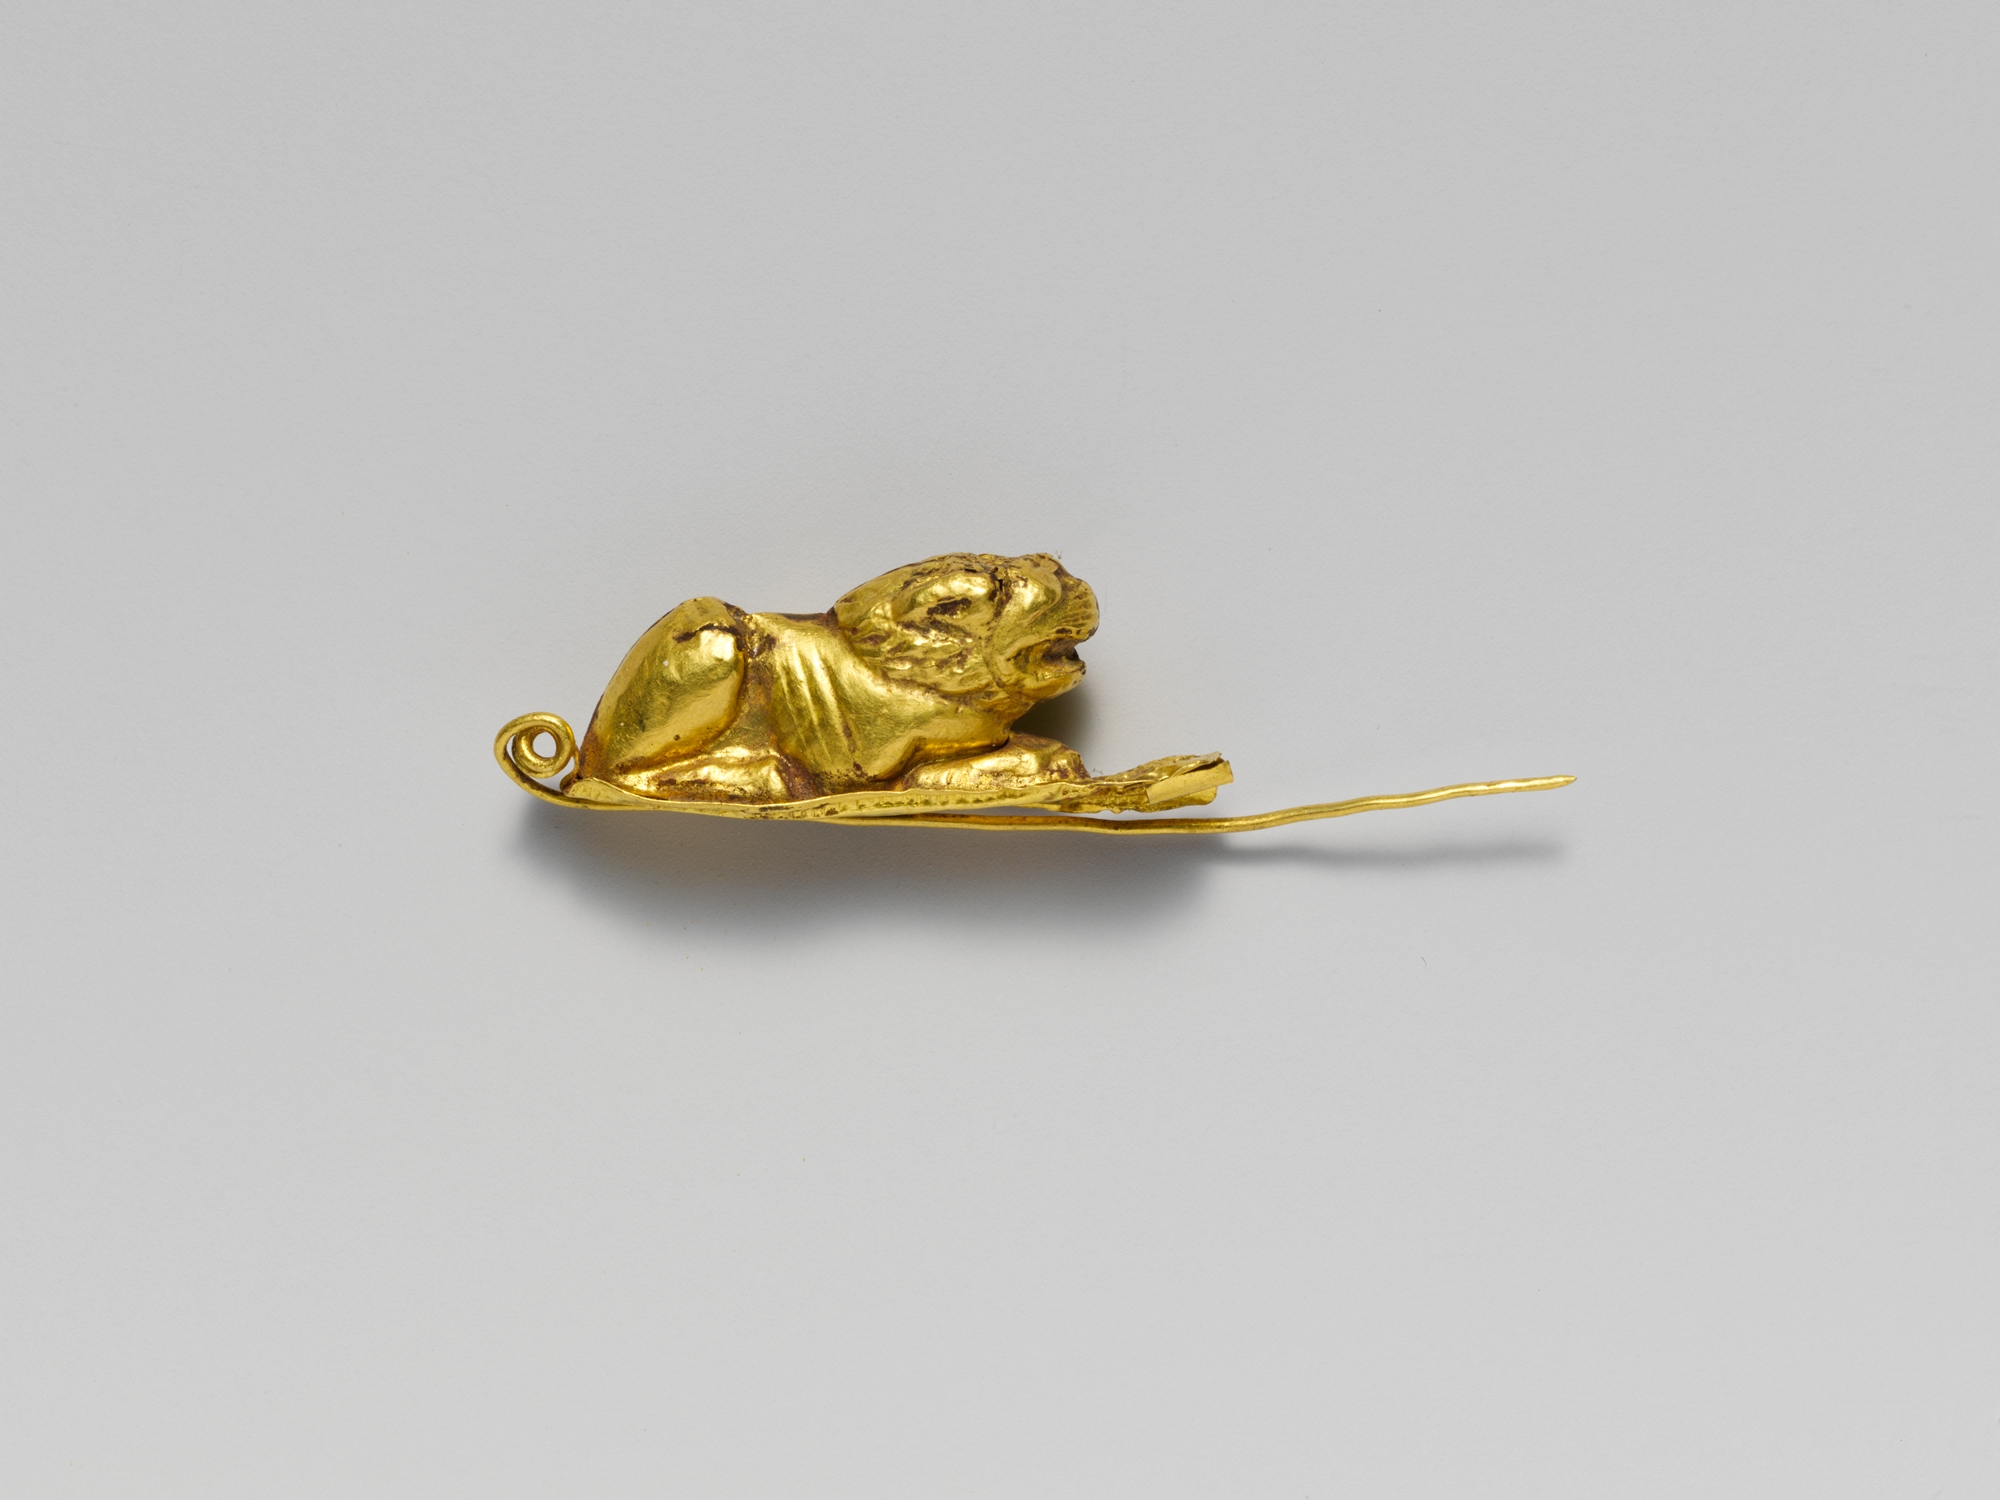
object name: fibula with recumbent lion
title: Gold fibula (safety pin) with recumbent lion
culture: etruscan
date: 600-401 BCE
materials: gold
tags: lions